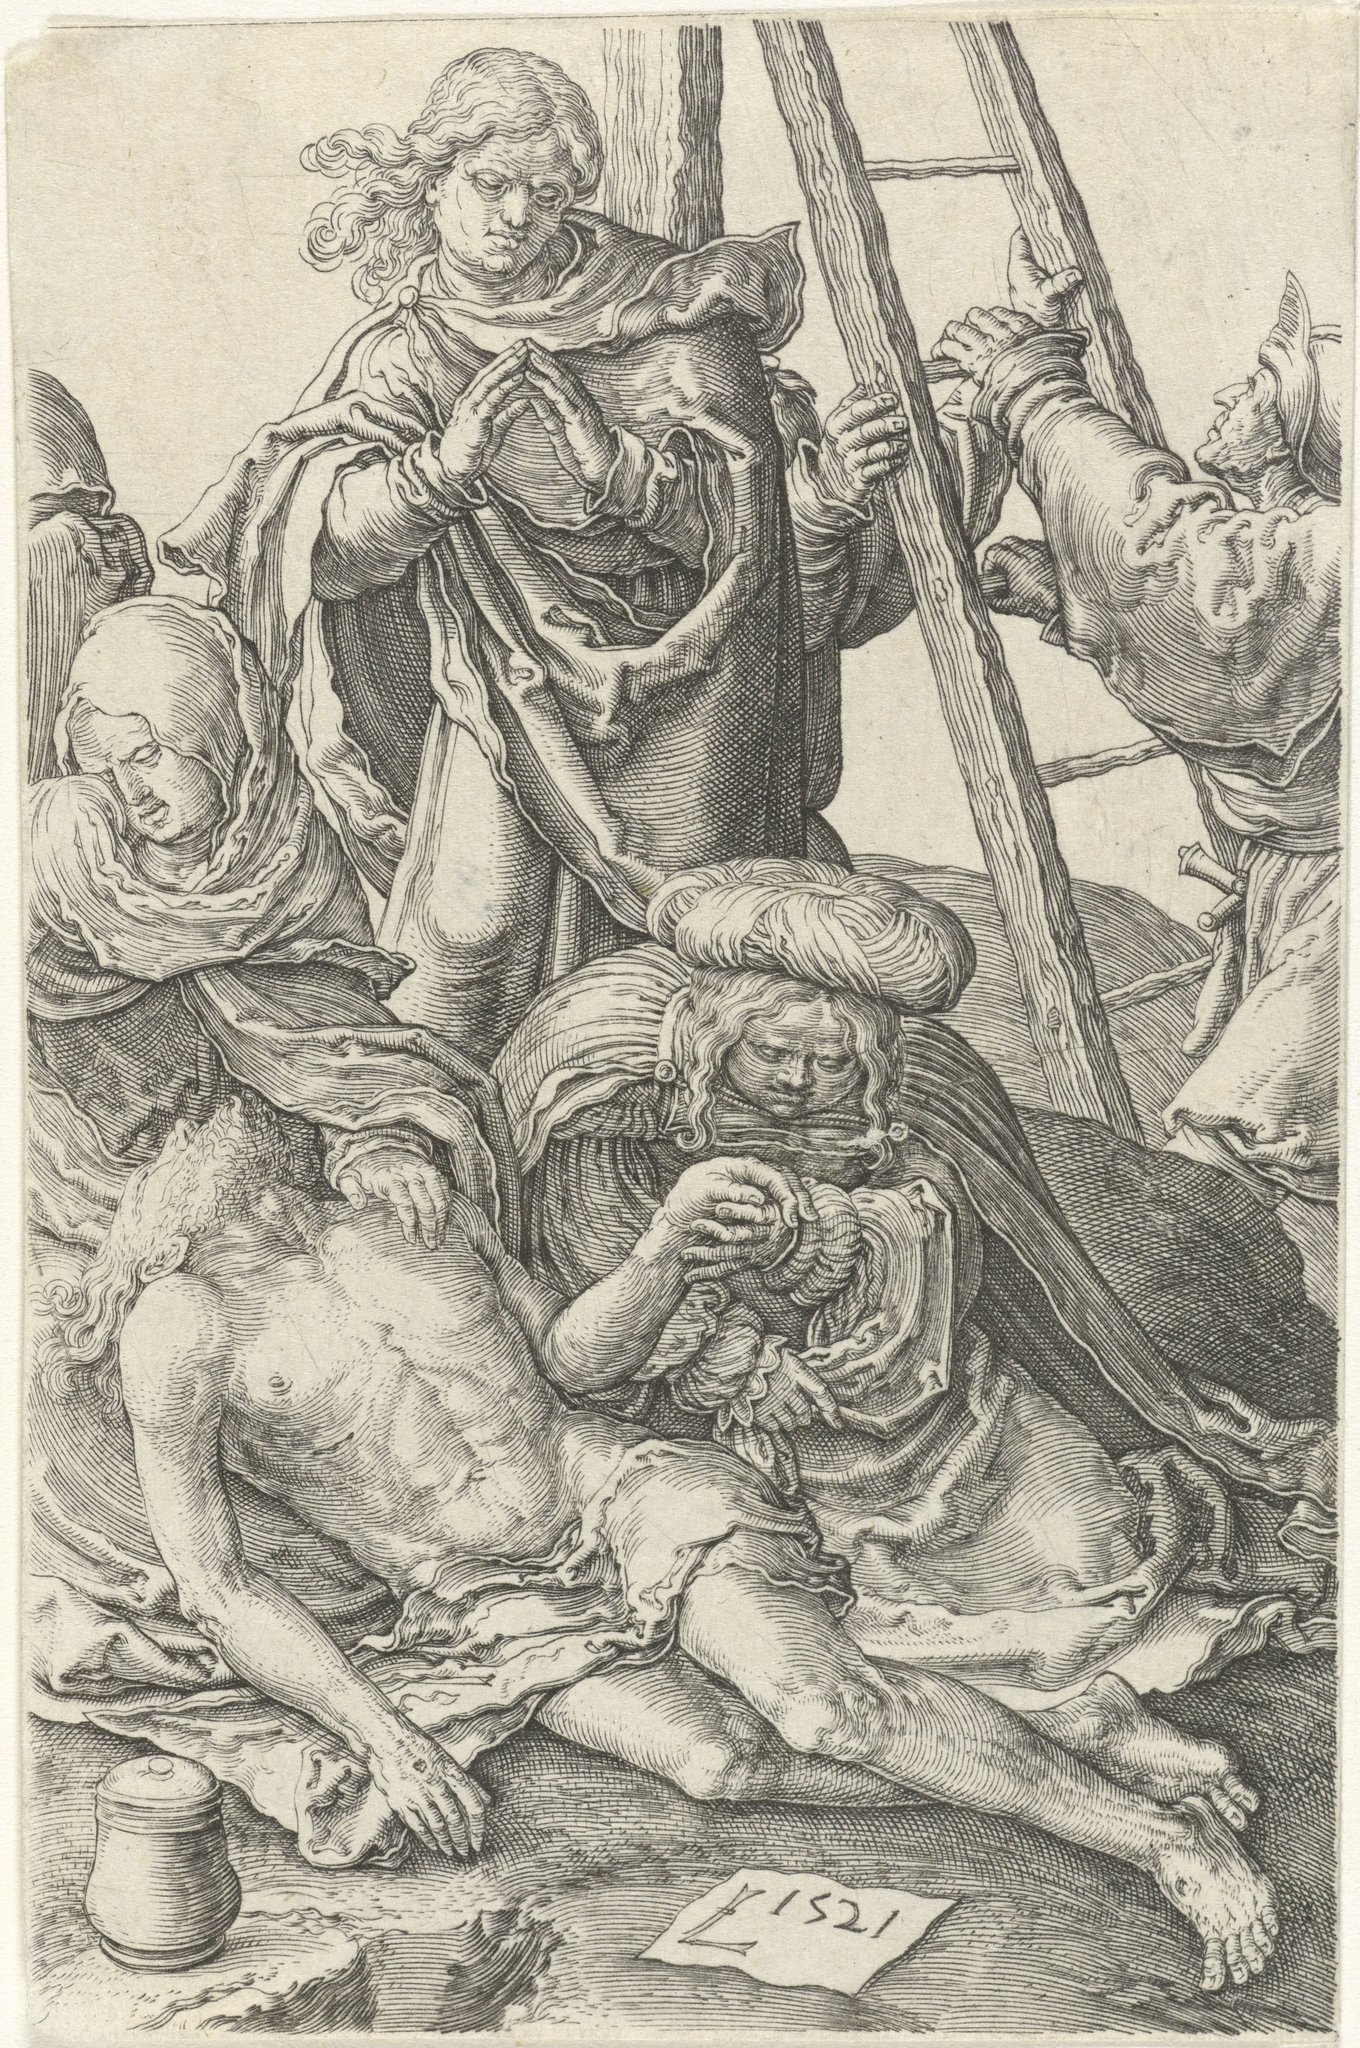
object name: print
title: Passie van Christus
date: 1613-1622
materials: paper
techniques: engraving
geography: amsterdam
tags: christ is laid down ~ descent from the cross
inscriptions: collector's mark: Lugt 2228, collector's mark: Lugt 2542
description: Christus is van het kruis afgenomen en wordt beweend door Maria en Maria Magdalena. Op de achtergrond Johannes. Links een zalfpot.